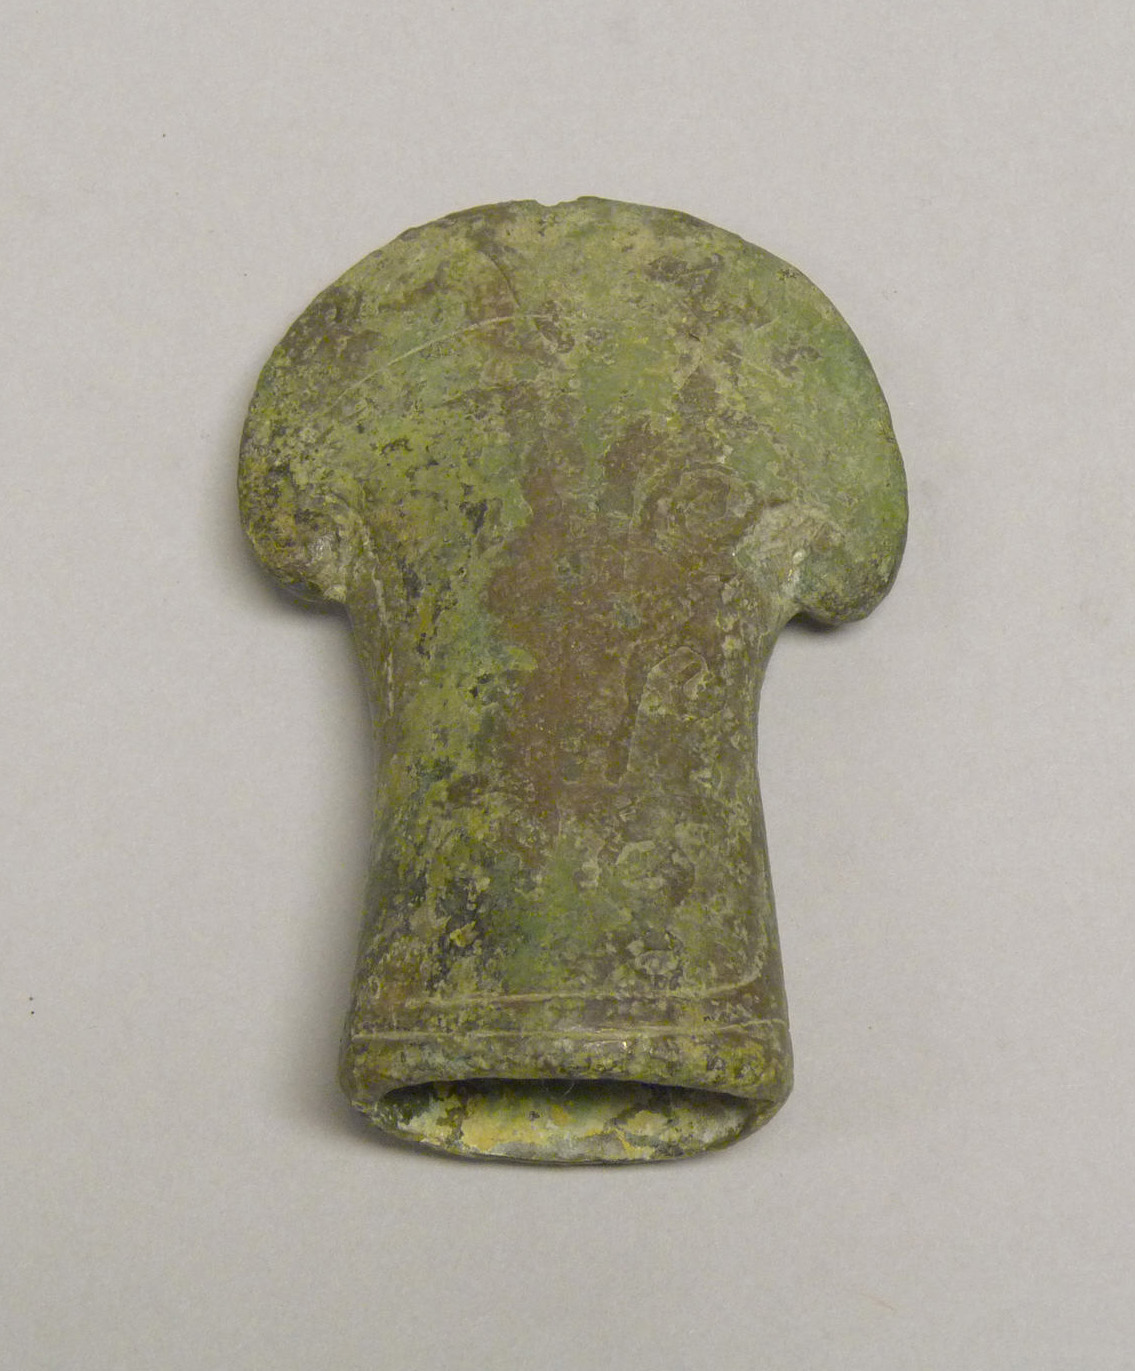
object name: hafted ax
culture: indonesian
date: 500 BCE-300 CE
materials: bronze